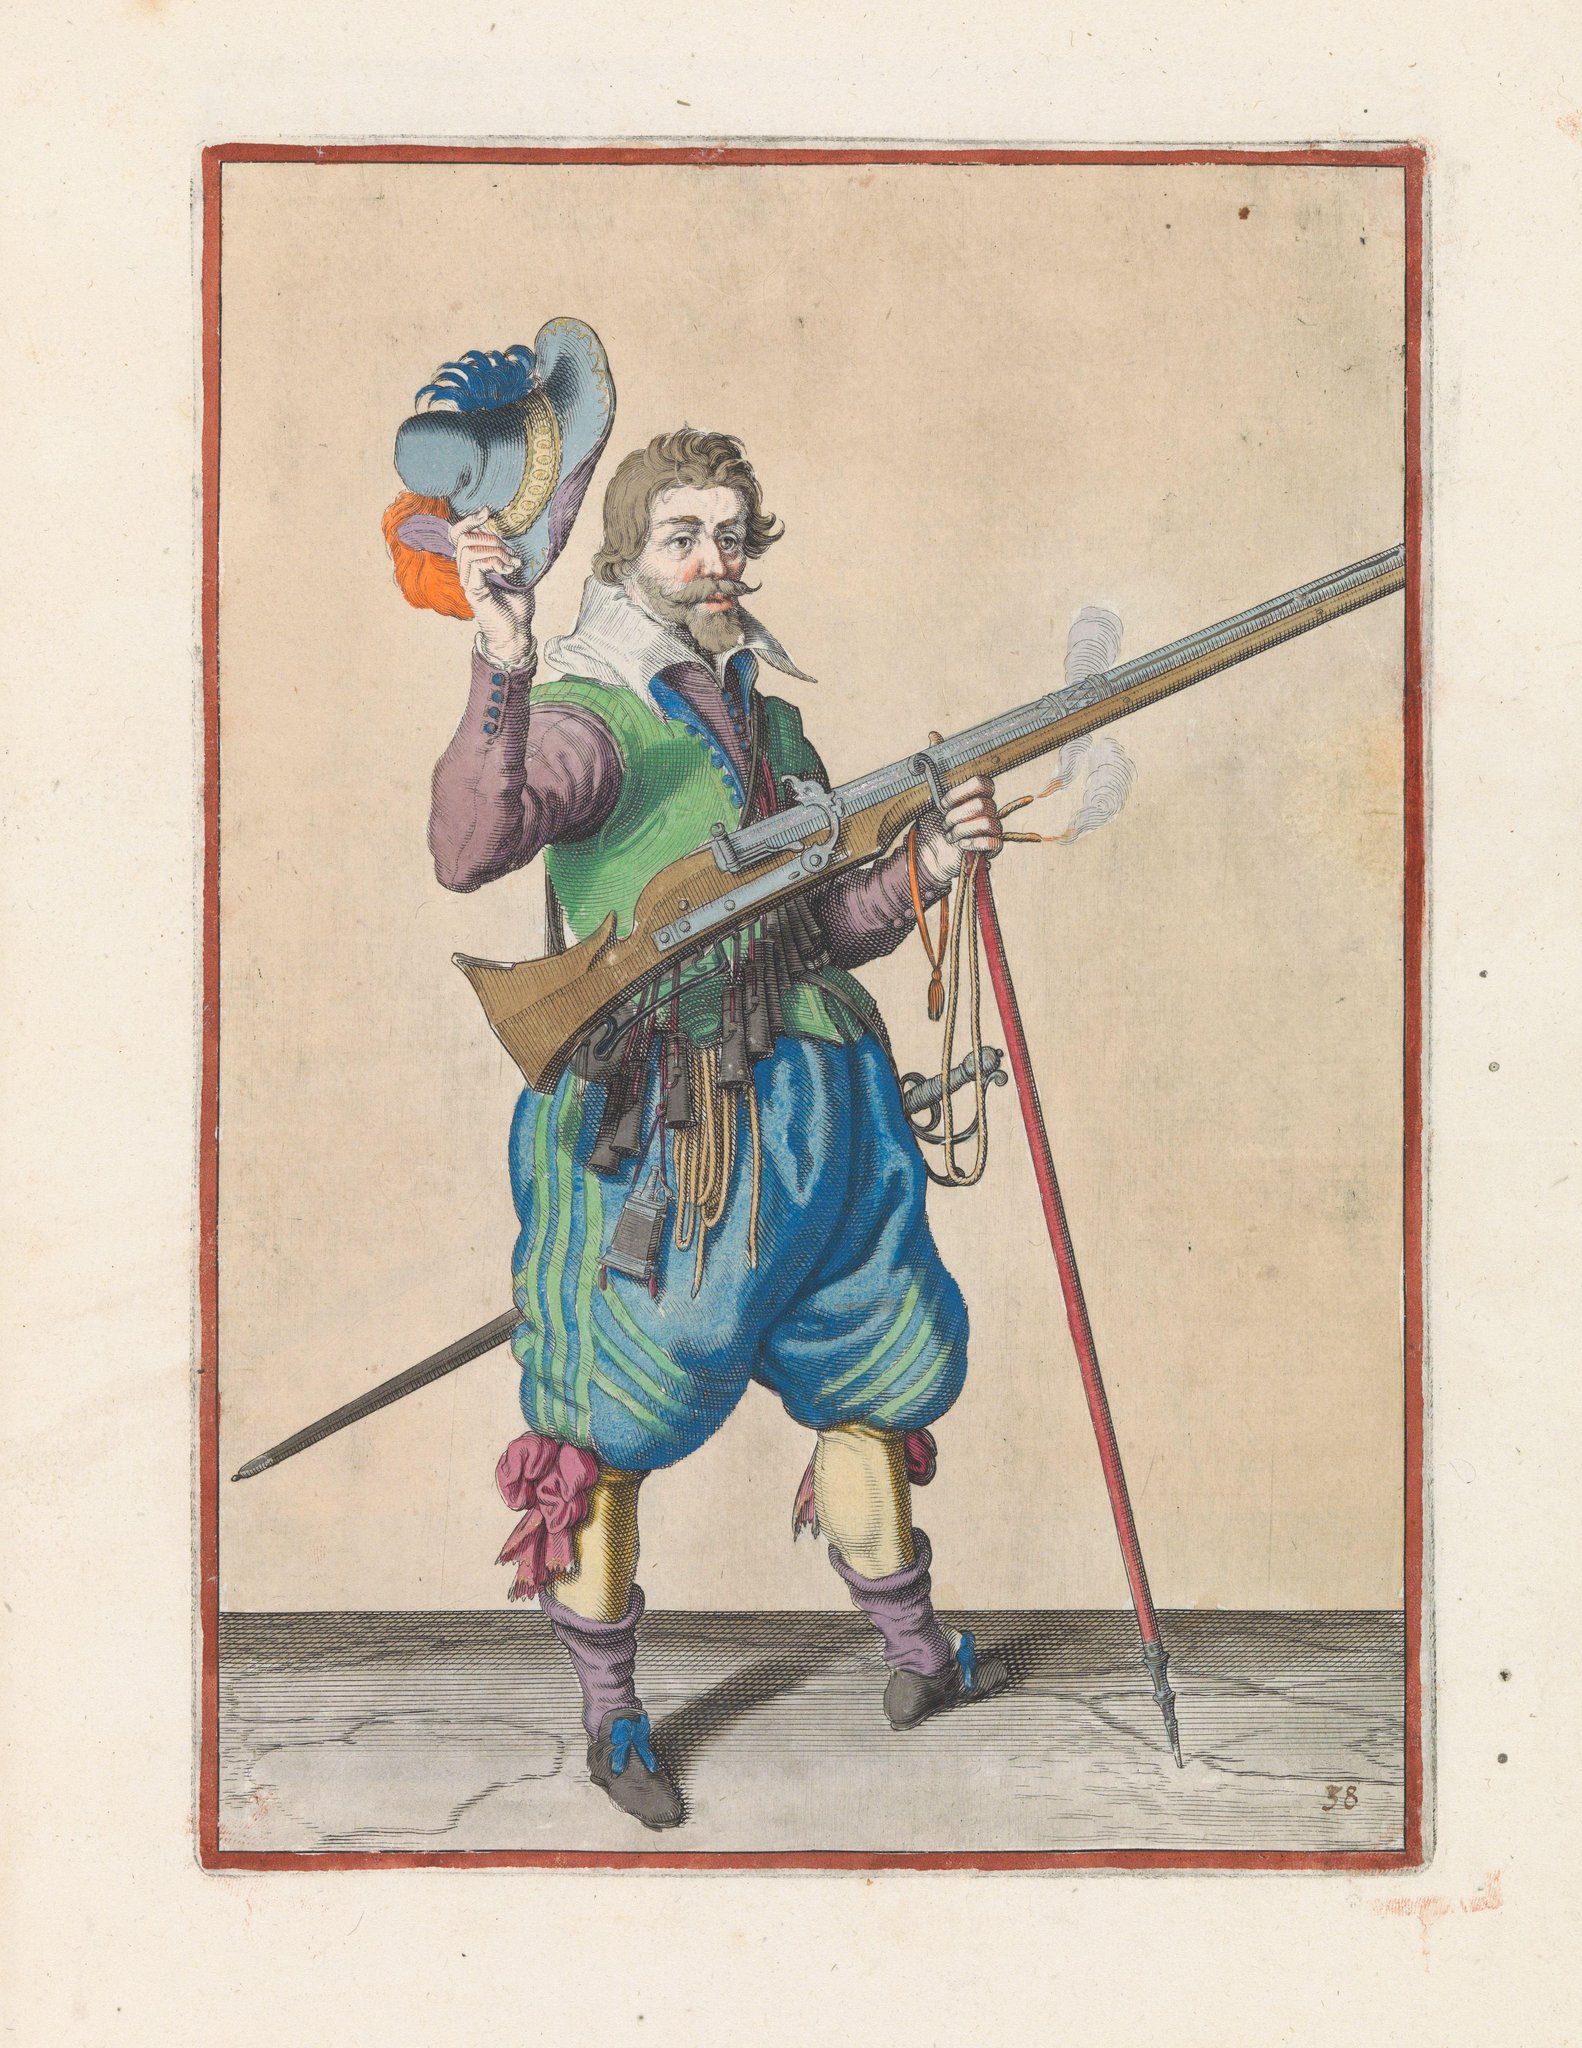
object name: print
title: Soldaat op wacht die zijn musket met zijn linkerhand bij zijn rechterzijde schuin omhoog gericht vasthoudt, terwijl hij met zijn rechterhand zijn hoed afneemt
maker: jacques de gheyn (ii)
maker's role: painter, print maker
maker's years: 1565-1629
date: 1597-1607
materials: paper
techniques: engraving, hand coloring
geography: the hague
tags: handling of weapons ~ military training, firearms: rifle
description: Een soldaat op wacht, ten voeten uit, naar rechts, die een musket (een bepaald type vuurwapen) bij zijn rechterzijde vasthoudt, zijn linkerhand om de vork van het furket (musketvork) waarop de loop, schuin omhoog gericht, rust. In zijn linkerhand tevens een brandende lont. Met zijn rechterhand neemt de soldaat zijn hoed af. Deze prent is onderdeel van de reeks van 43 met de hand genummerde prenten van musketiers in de Wapenhandelinghe.